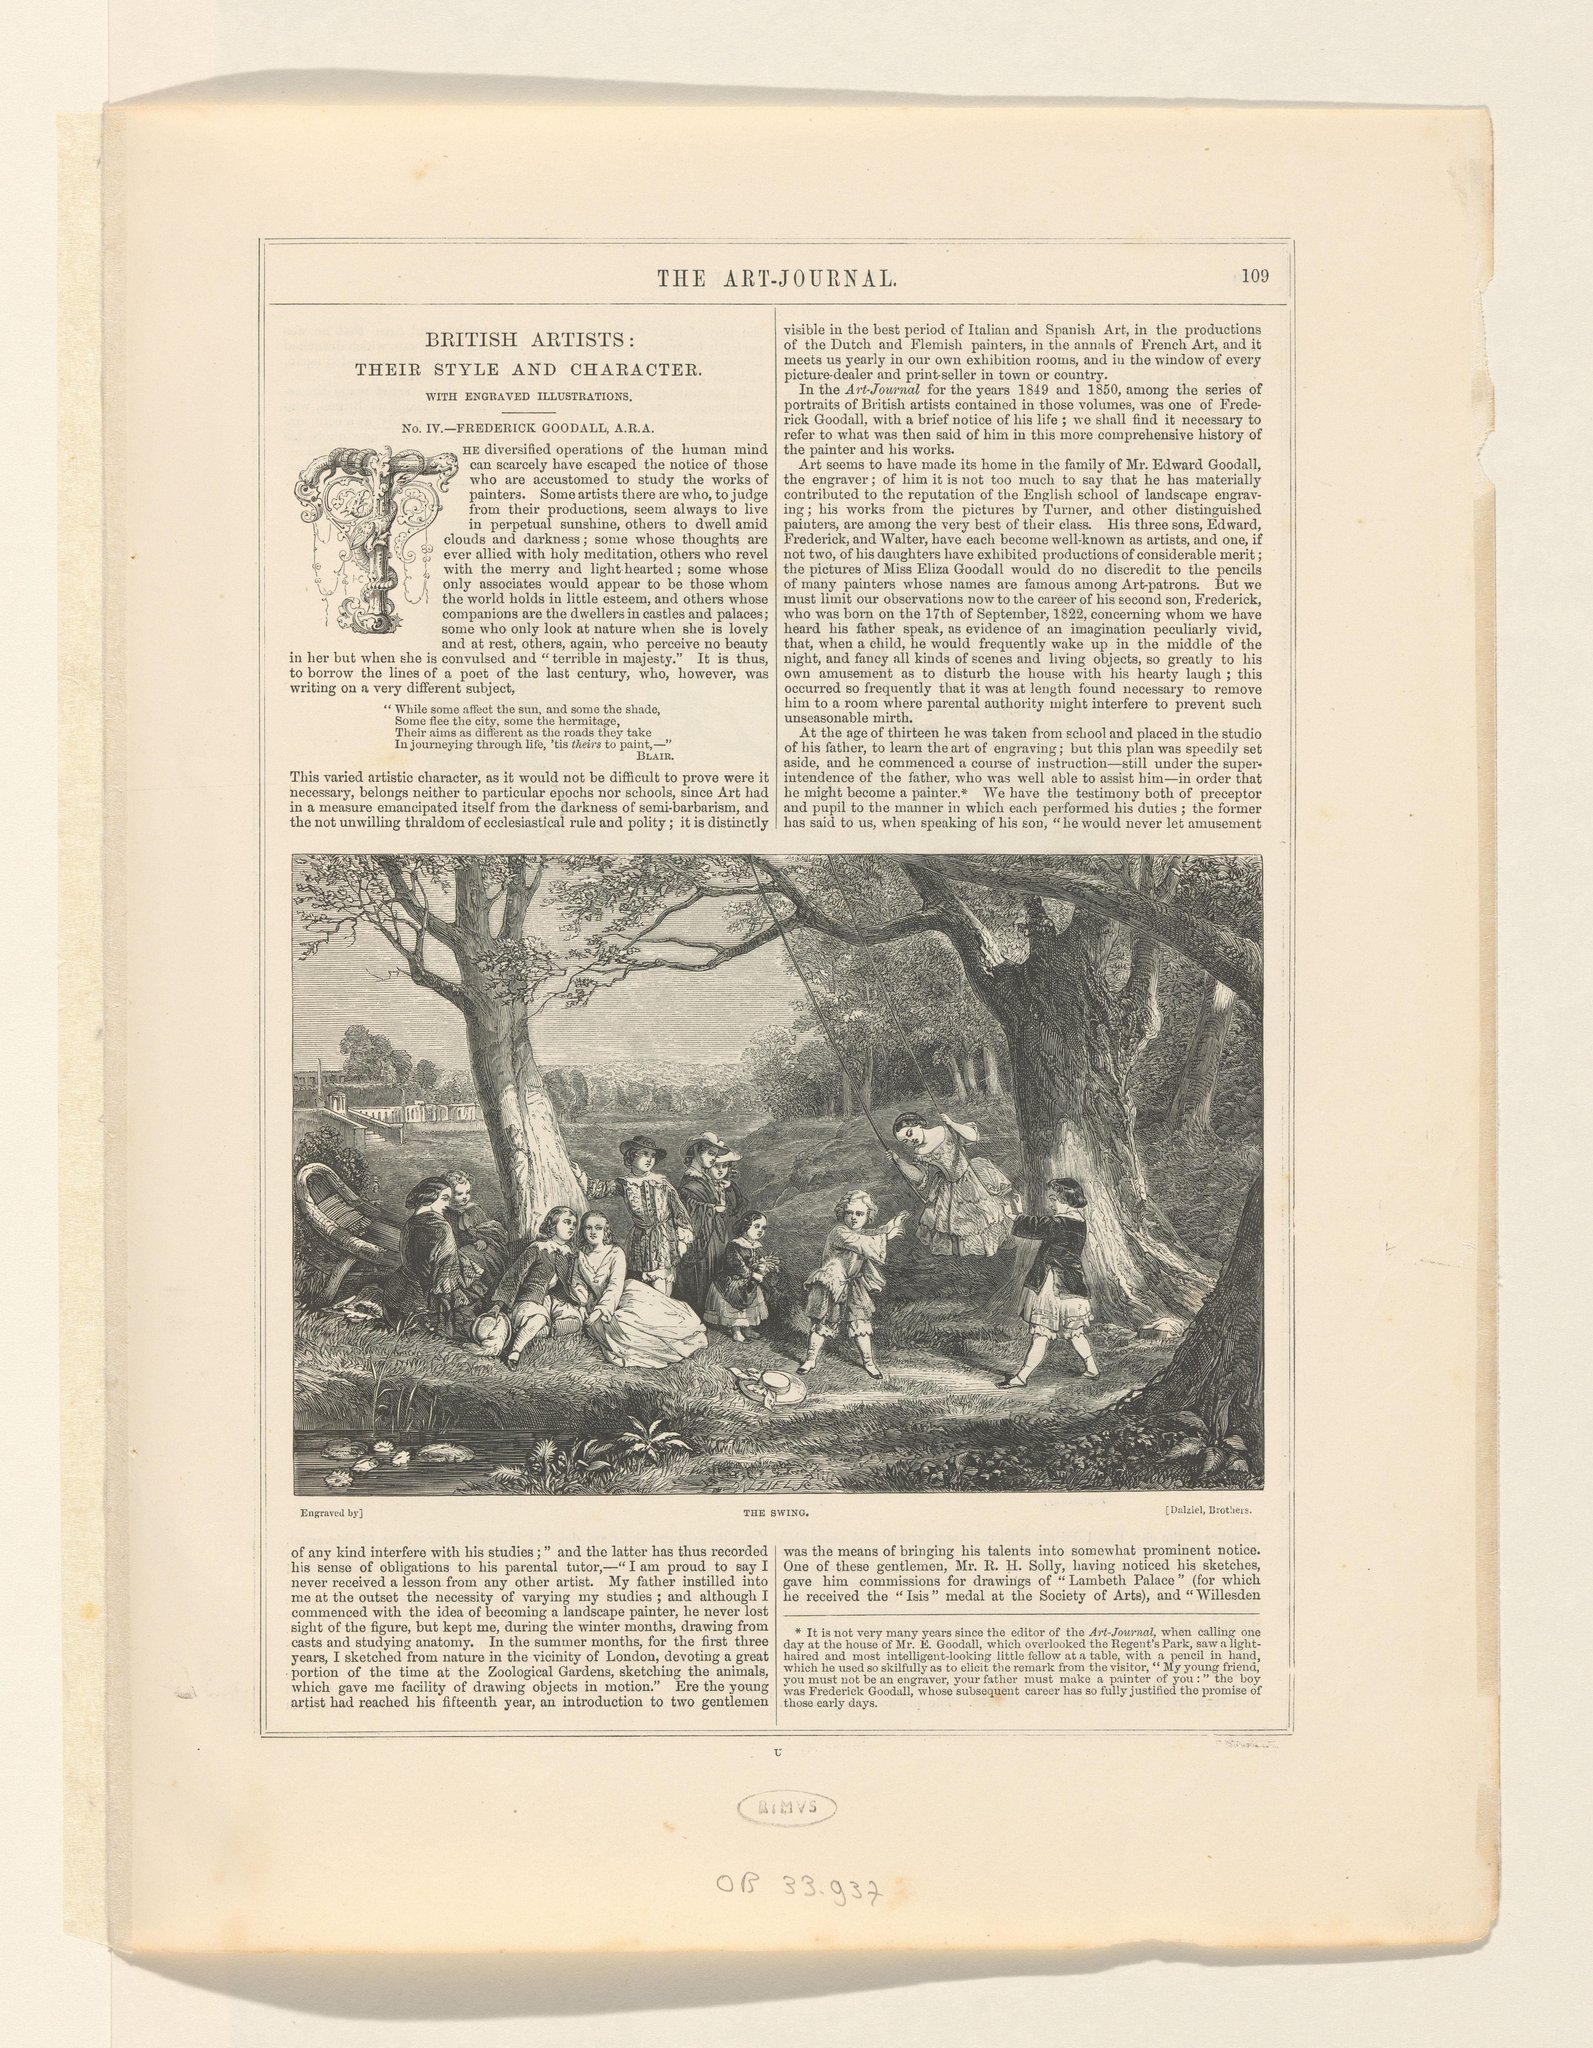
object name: print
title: The swing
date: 1855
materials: paper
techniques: letterpress printing, engraving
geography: london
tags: child (+ more than eight persons), swinging (children's game), landscapes (+ landscape with figures, staffage)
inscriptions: collector's mark: Lugt 2228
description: Prent uit: The Art Journal 4 (1855), p. 109.